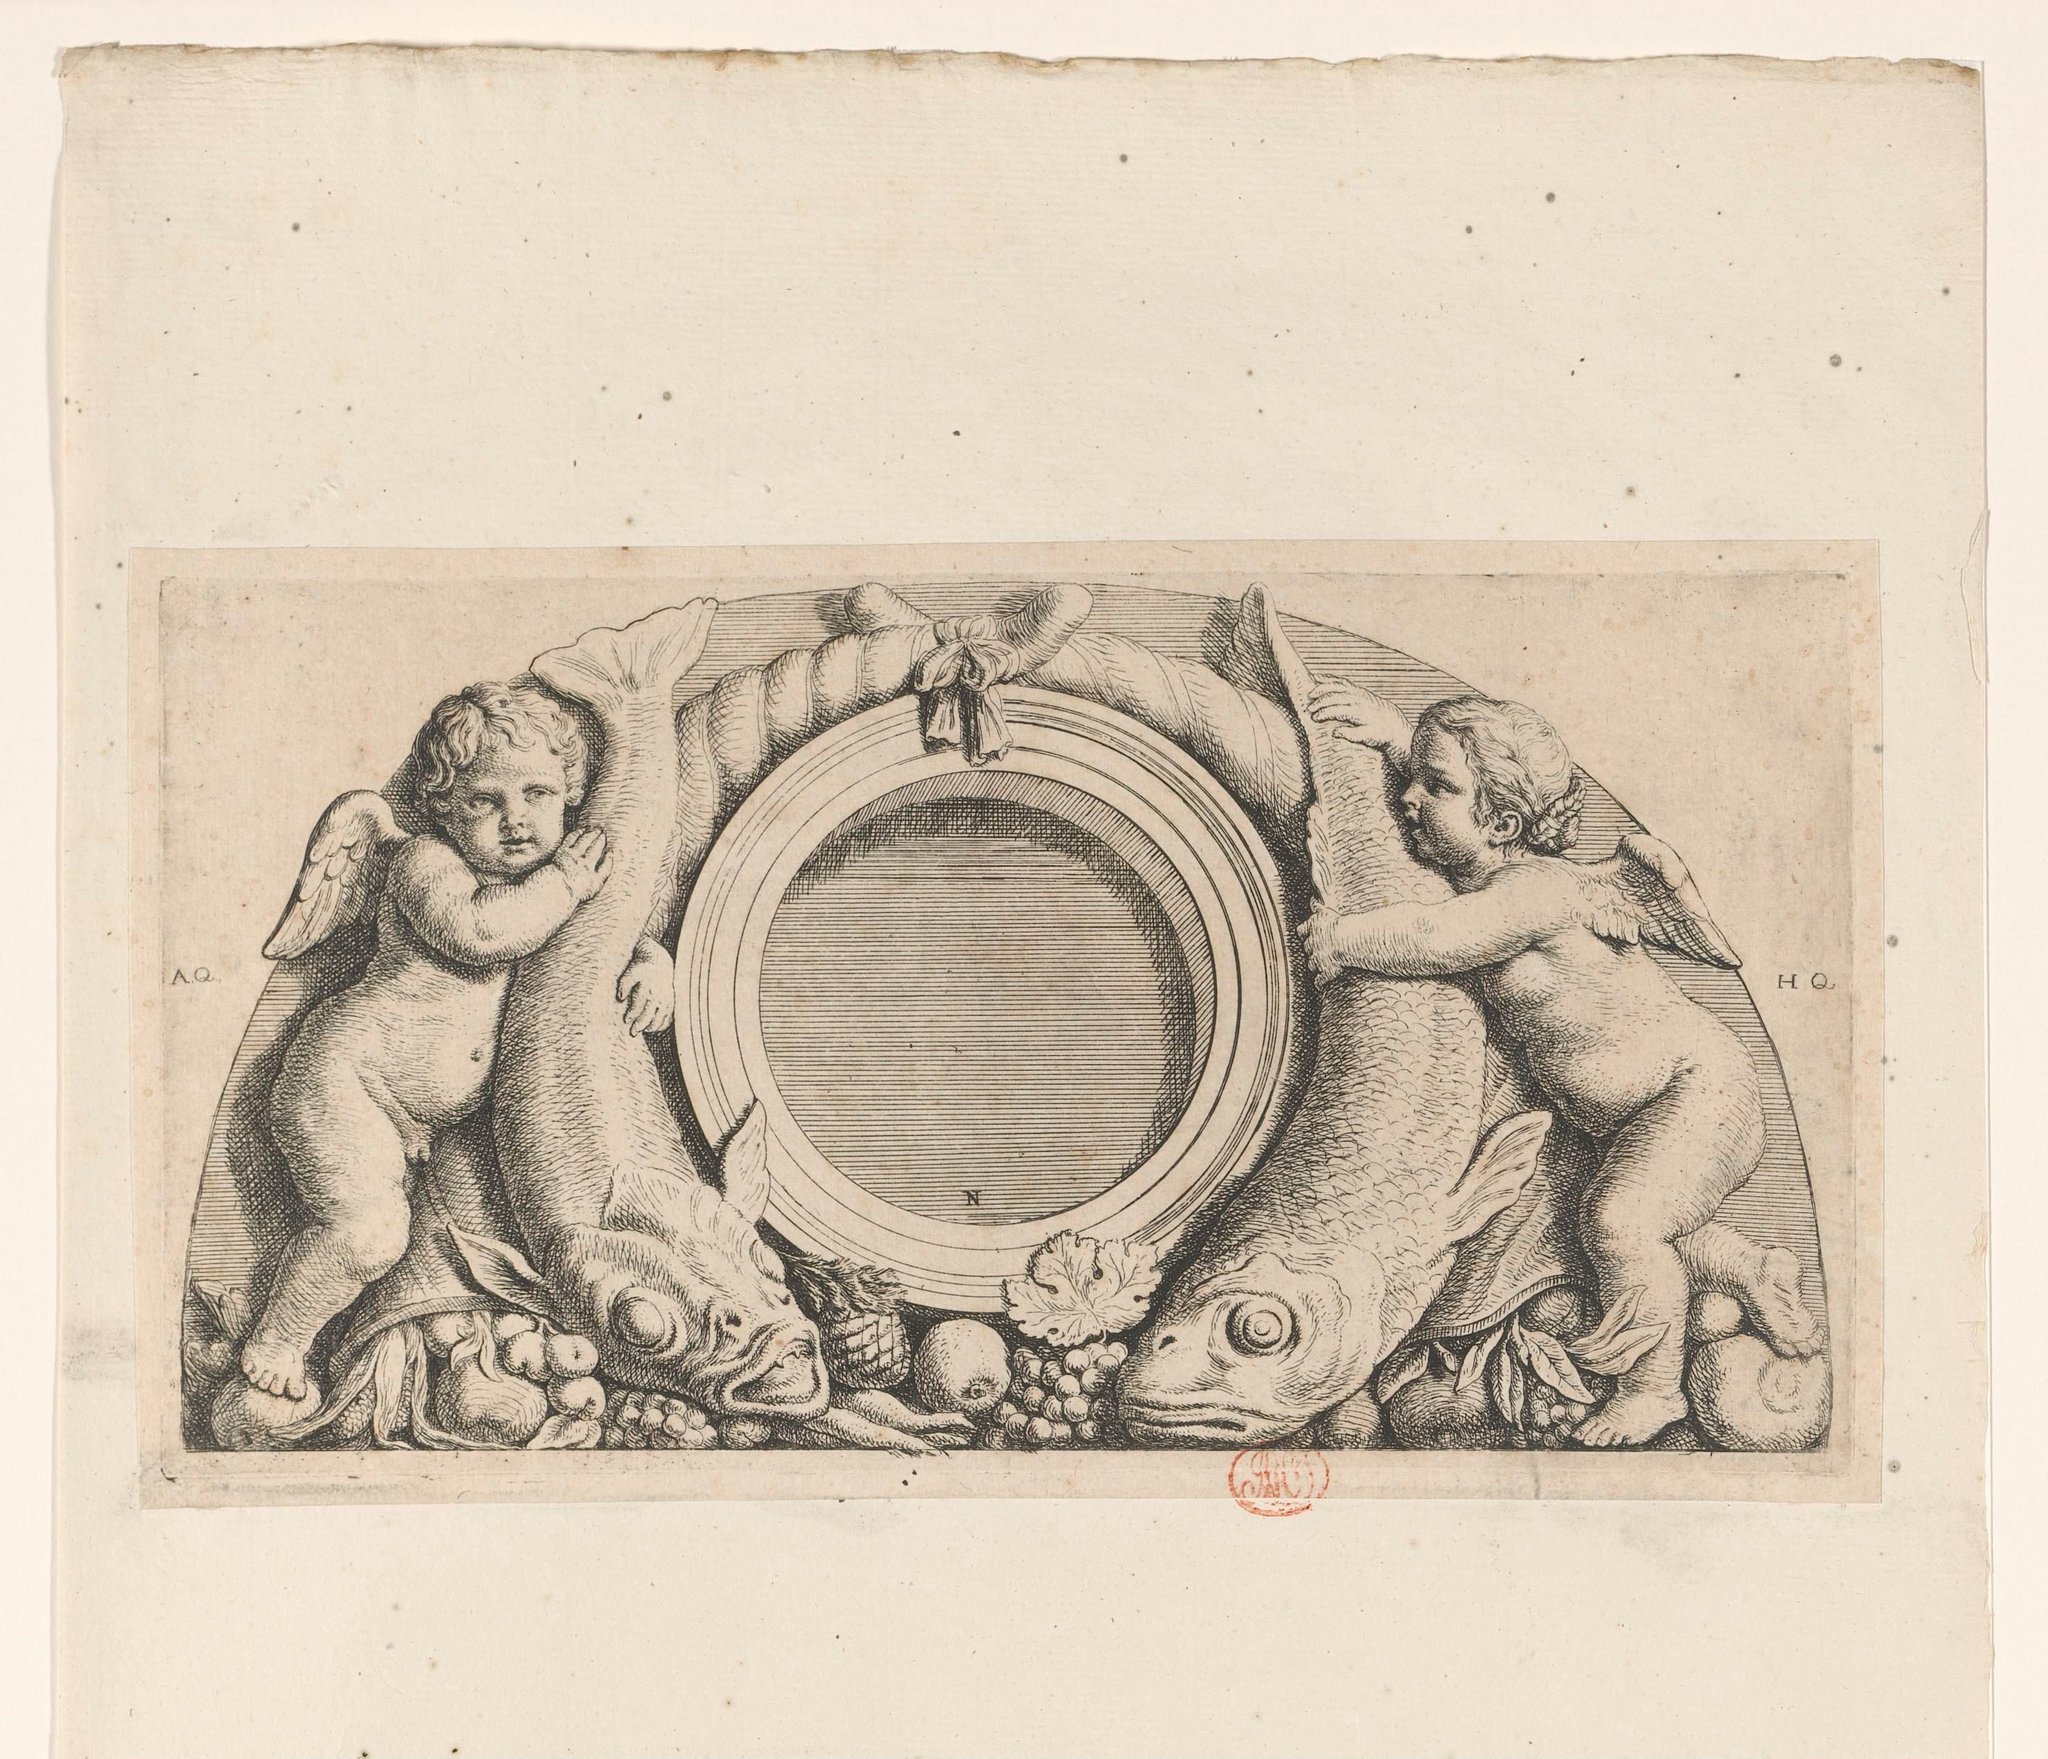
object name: book illustration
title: Lunette met putti, vissen en hoornen des overvloeds in de oostelijke galerij van het Stadhuis op de Dam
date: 1655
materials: paper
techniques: engraving, etching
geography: amsterdam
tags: 'cornucopia', horn of plenty, fishes, cupids: 'amores', 'amoretti', 'putti'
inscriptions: collector's mark: Lugt 195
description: Prent gebruikt in: Prima pars. Praecipuarum effigierum ac ornamentorum, amplissimae Curiae Amstelrodamensis (…) / Het eerste deel. Van de voornaemste Statuen ende Ciraten, vant konstijck Stadhuys van Amstelredam, tmeeste in marmer gemaeckt, door Artus Quellinus, Beelthouwer der voorseyde Stadt / La Premier Partie. De plusieurs Figures et ornements, de la Maison de Ville d'Amsterdam (…). Amsterdam: Artus Quellinus (I), 1655. Zie RP-P-AO-22-1-1 voor bijhorende titelpagina. Zie RP-P-AO-22-1-2 voor bijhorend register. Zie RP-P-AO-22-1A, RP-P-AO-22-1B, RP-P-AO-22-1C, RP-P-AO-22-1D-1, RP-P-AO-22-1D-2, RP-P-AO-22-1E, RP-P-AO-22-1F, RP-P-AO-22-1G, RP-P-AO-22-1H, RP-P-AO-22-1I, RP-P-AO-22-1K-1, RP-P-AO-22-1K-2, RP-P-AO-22-1K-3, RP-P-AO-22-1K-4, RP-P-AO-22-1K-5, RP-P-AO-22-1L-1, RP-P-AO-22-1L-2, RP-P-AO-22-1M-1, RP-P-AO-22-1M-2, RP-P-AO-22-1N-1, RP-P-AO-22-1N-3, RP-P-AO-22-1N-4, RP-P-AO-22-1N-5, RP-P-AO-22-1O-1, RP-P-AO-22-1O-2, RP-P-AO-22-1O-3, RP-P-AO-22-1O-4, RP-P-AO-22-1P-1, RP-P-AO-22-1P-2, RP-P-AO-22-1P-3, RP-P-AO-22-1P-4, RP-P-AO-22-1Q-1, RP-P-AO-22-1Q-2, RP-P-AO-22-1Q-3, RP-P-AO-22-1Q-4, RP-P-AO-22-1R-1, RP-P-AO-22-1R-2, RP-P-AO-22-1R-3, RP-P-AO-22-1R-4, RP-P-AO-22-1R-5, RP-P-AO-22-1S-1, RP-P-AO-22-1S-2, RP-P-AO-22-1S-3, RP-P-AO-22-1S-4, RP-P-AO-22-1S-5, RP-P-AO-22-1T-1 en RP-P-AO-22-1T-2 voor andere prenten uit deze publicatie. Zelfde staat van prent ook gebruikt in: Prima pars. Praecipuarum effigierum ac ornamentorum, amplissimae Curiae Amstelrodamensis (…) / Het eerste deel. Van de voornaemste Statuen ende Ciraten, vant konstijck Stadhuys van Amstelredam, tmeeste in marmer gemaeckt, door Artus Quellinus, Beelthouwer der voorseyde Stadt / La Premier Partie. De plusieurs Figures et ornements, de la Maison de Ville d'Amsterdam (…). Amsterdam: Frederik de Wit, 1665. Latere staat van prent ook gebruikt in: Architecture peinture et sculpture de la Maison de Ville d'Amsterdam, representee en CIX. figures en taille-douce (…). Amsterdam: David Mortier, 1719. En in: Architecture peinture et sculpture de la Maison de Ville d'Amsterdam, representee en CIX. figures en taille-douce (…). Amsterdam: Gerard Valck, 1719. En in: Bouw schilder en beeldhouwkonst, van het Stadhuis te Amsteldam, vertoont in CIX figuuren (…). Amsterdam: Covens & Mortier & Covens Jr., s.a. (1774-1783).